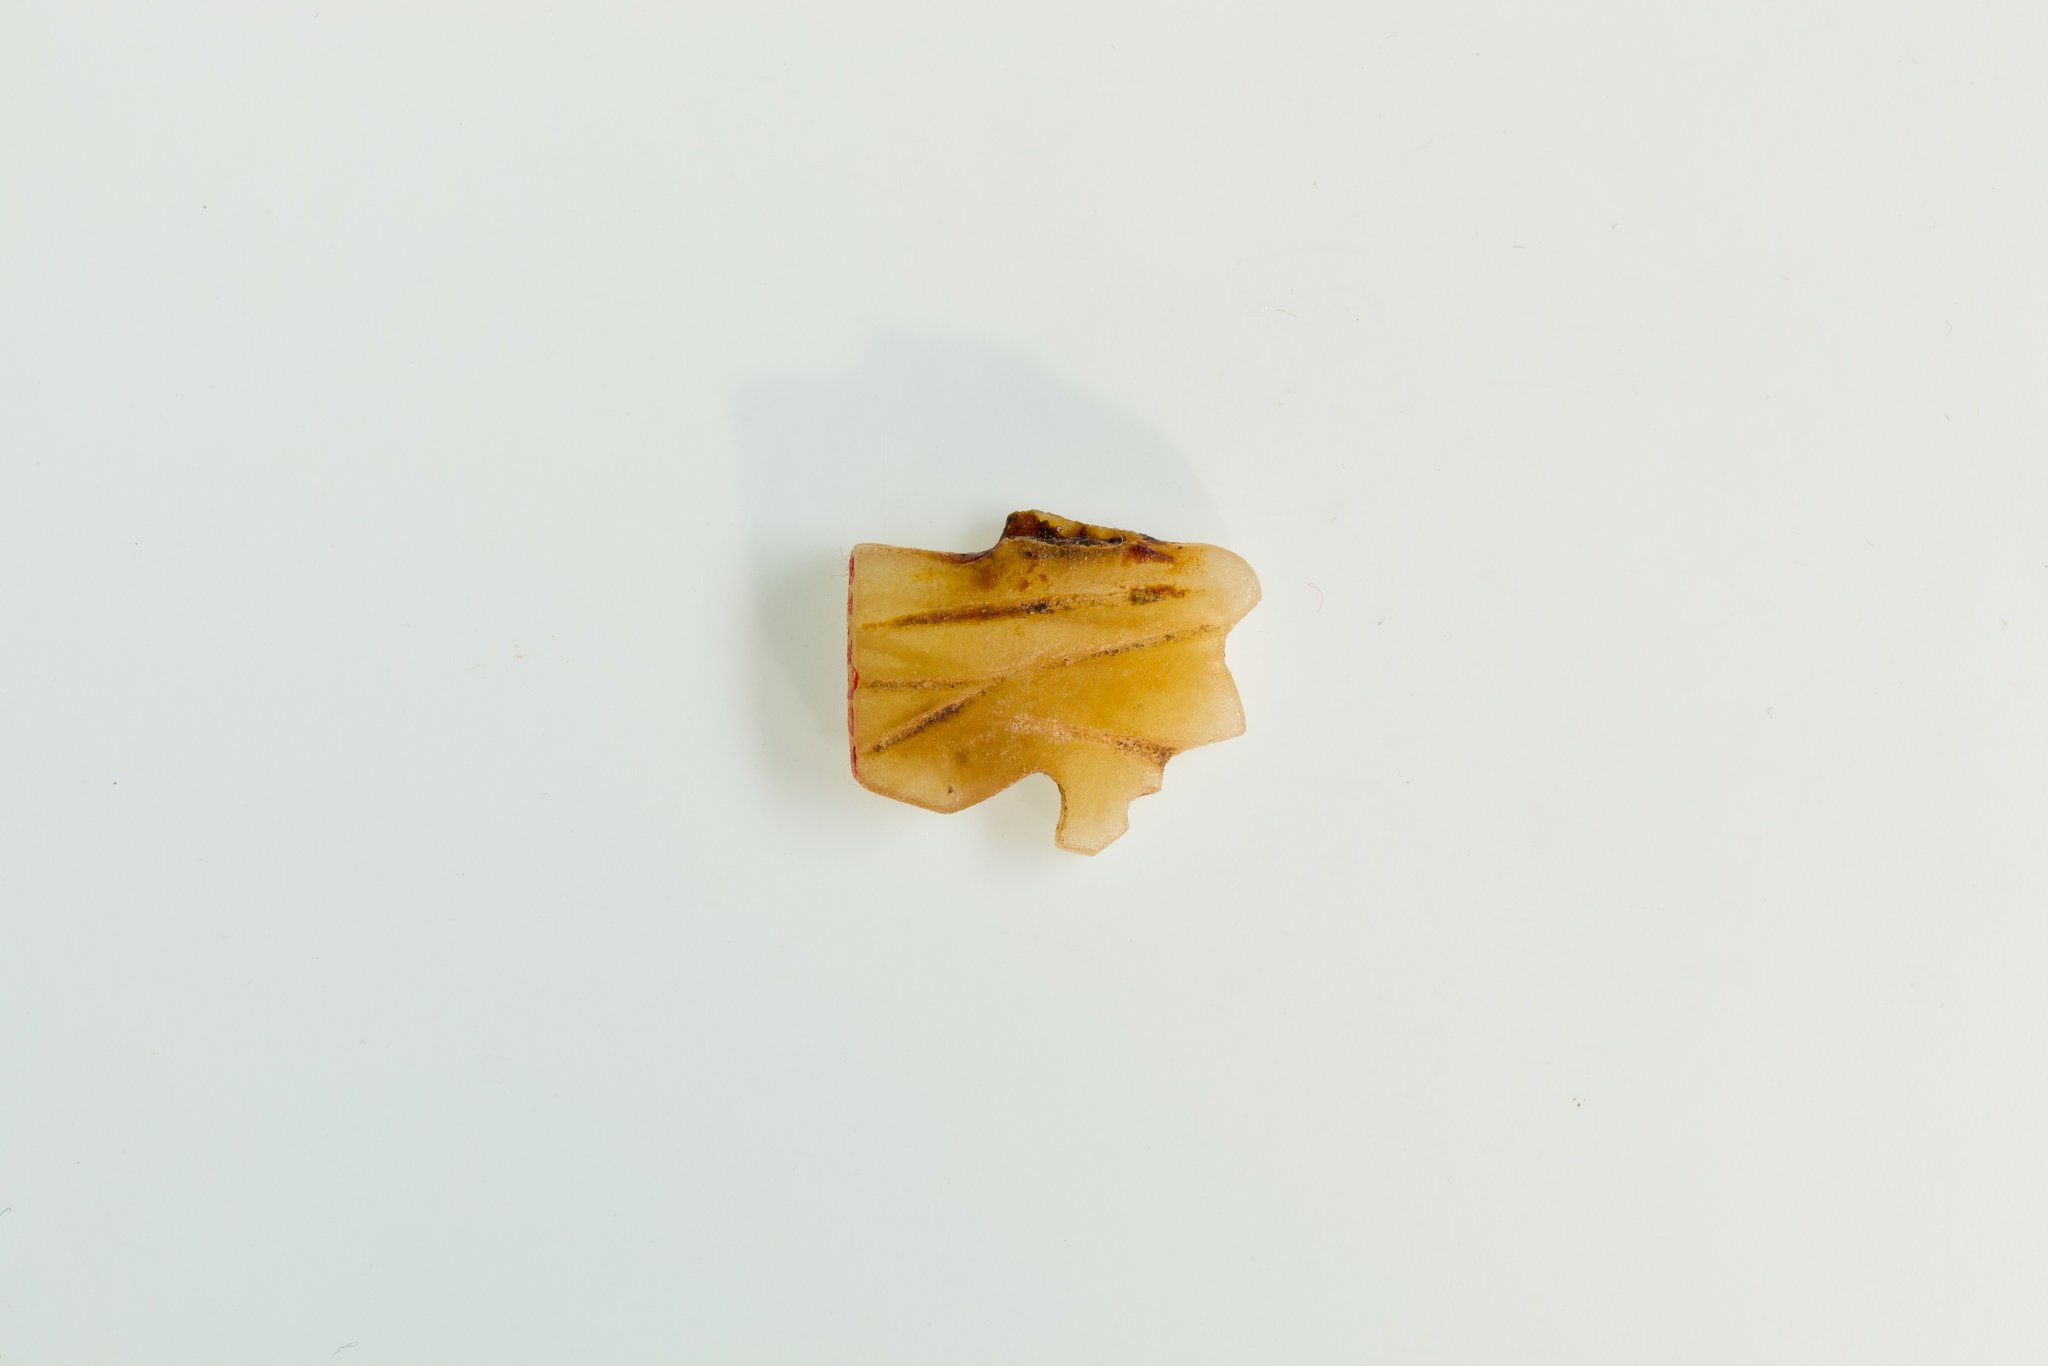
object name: amulet, wedjat eye, tiye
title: Wedjat Amulet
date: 1070-945 BCE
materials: gemstone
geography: egypt